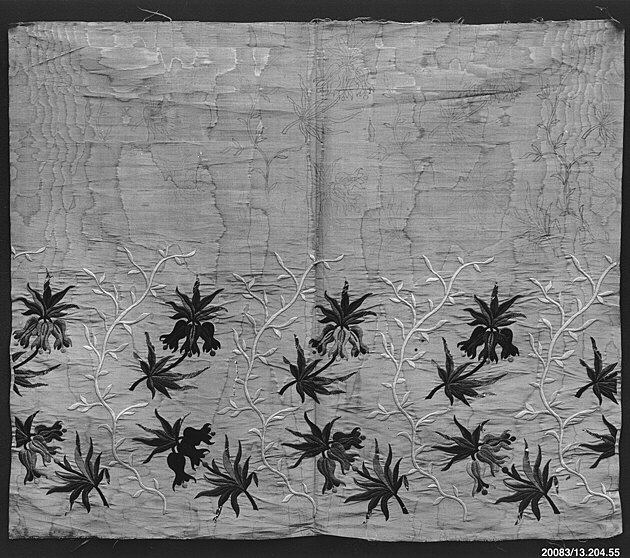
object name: fragment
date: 1701-1800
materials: metal thread, silk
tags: leaves